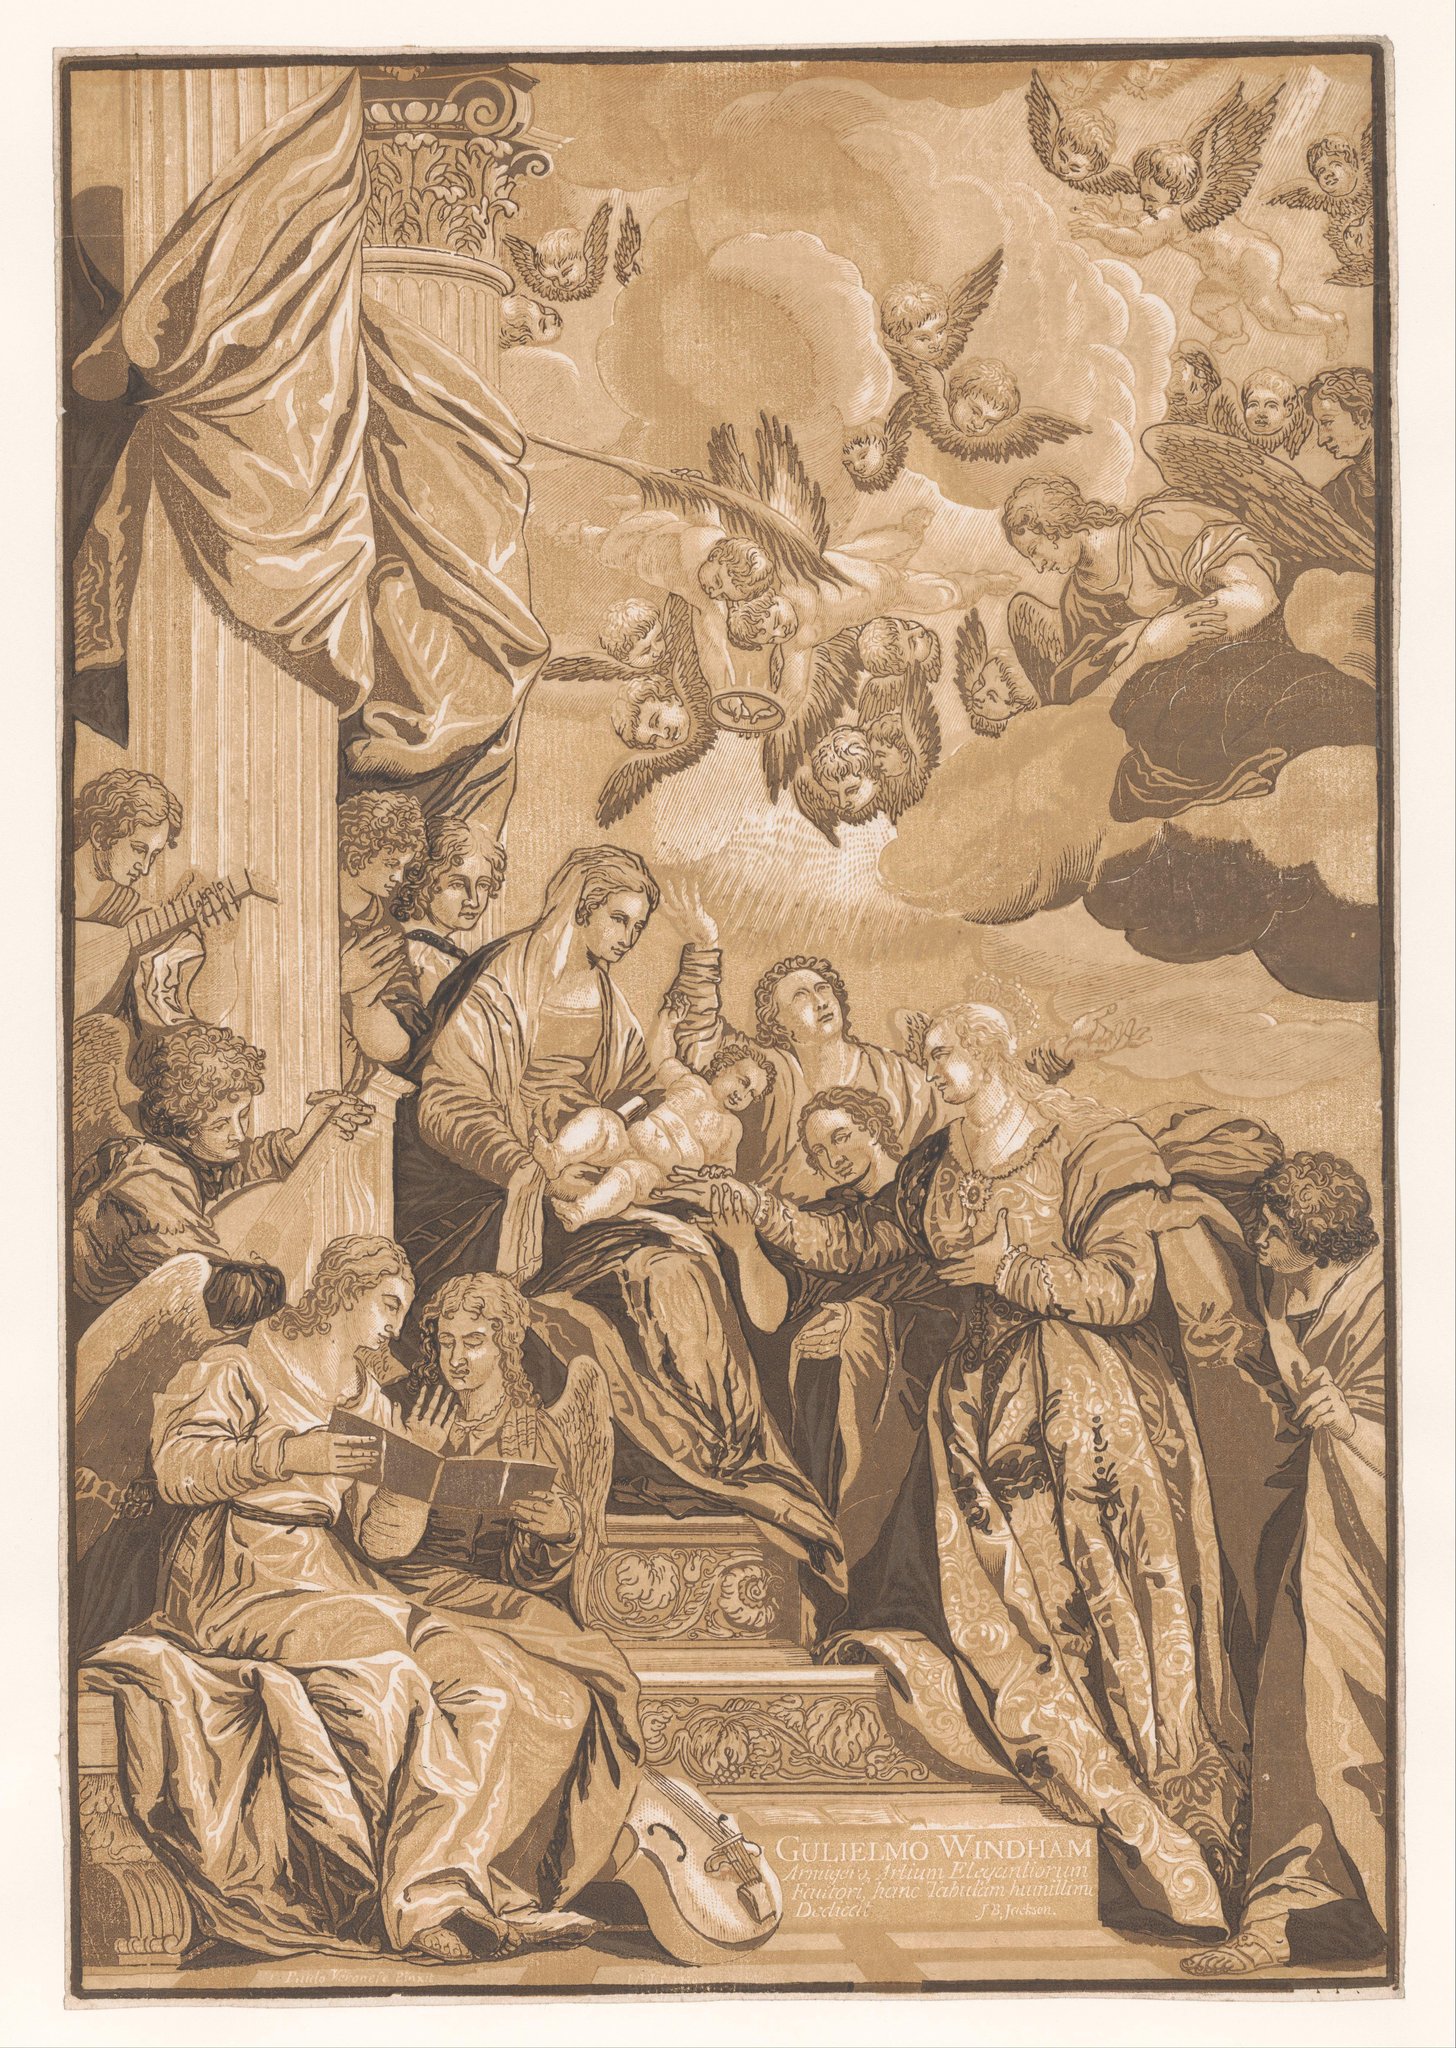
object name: print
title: Kunstwerken van Venetiaanse meesters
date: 1745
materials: paper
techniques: woodcut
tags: the mystic marriage of st. catherine of alexandria with the infant christ: the christ-child puts a ring on her finger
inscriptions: collector's mark: Lugt 2760, collector's mark: Lugt 2228, collector's mark: Lugt 1060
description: Prent maakt deel uit van een ongenummerde serie van 24 prenten.